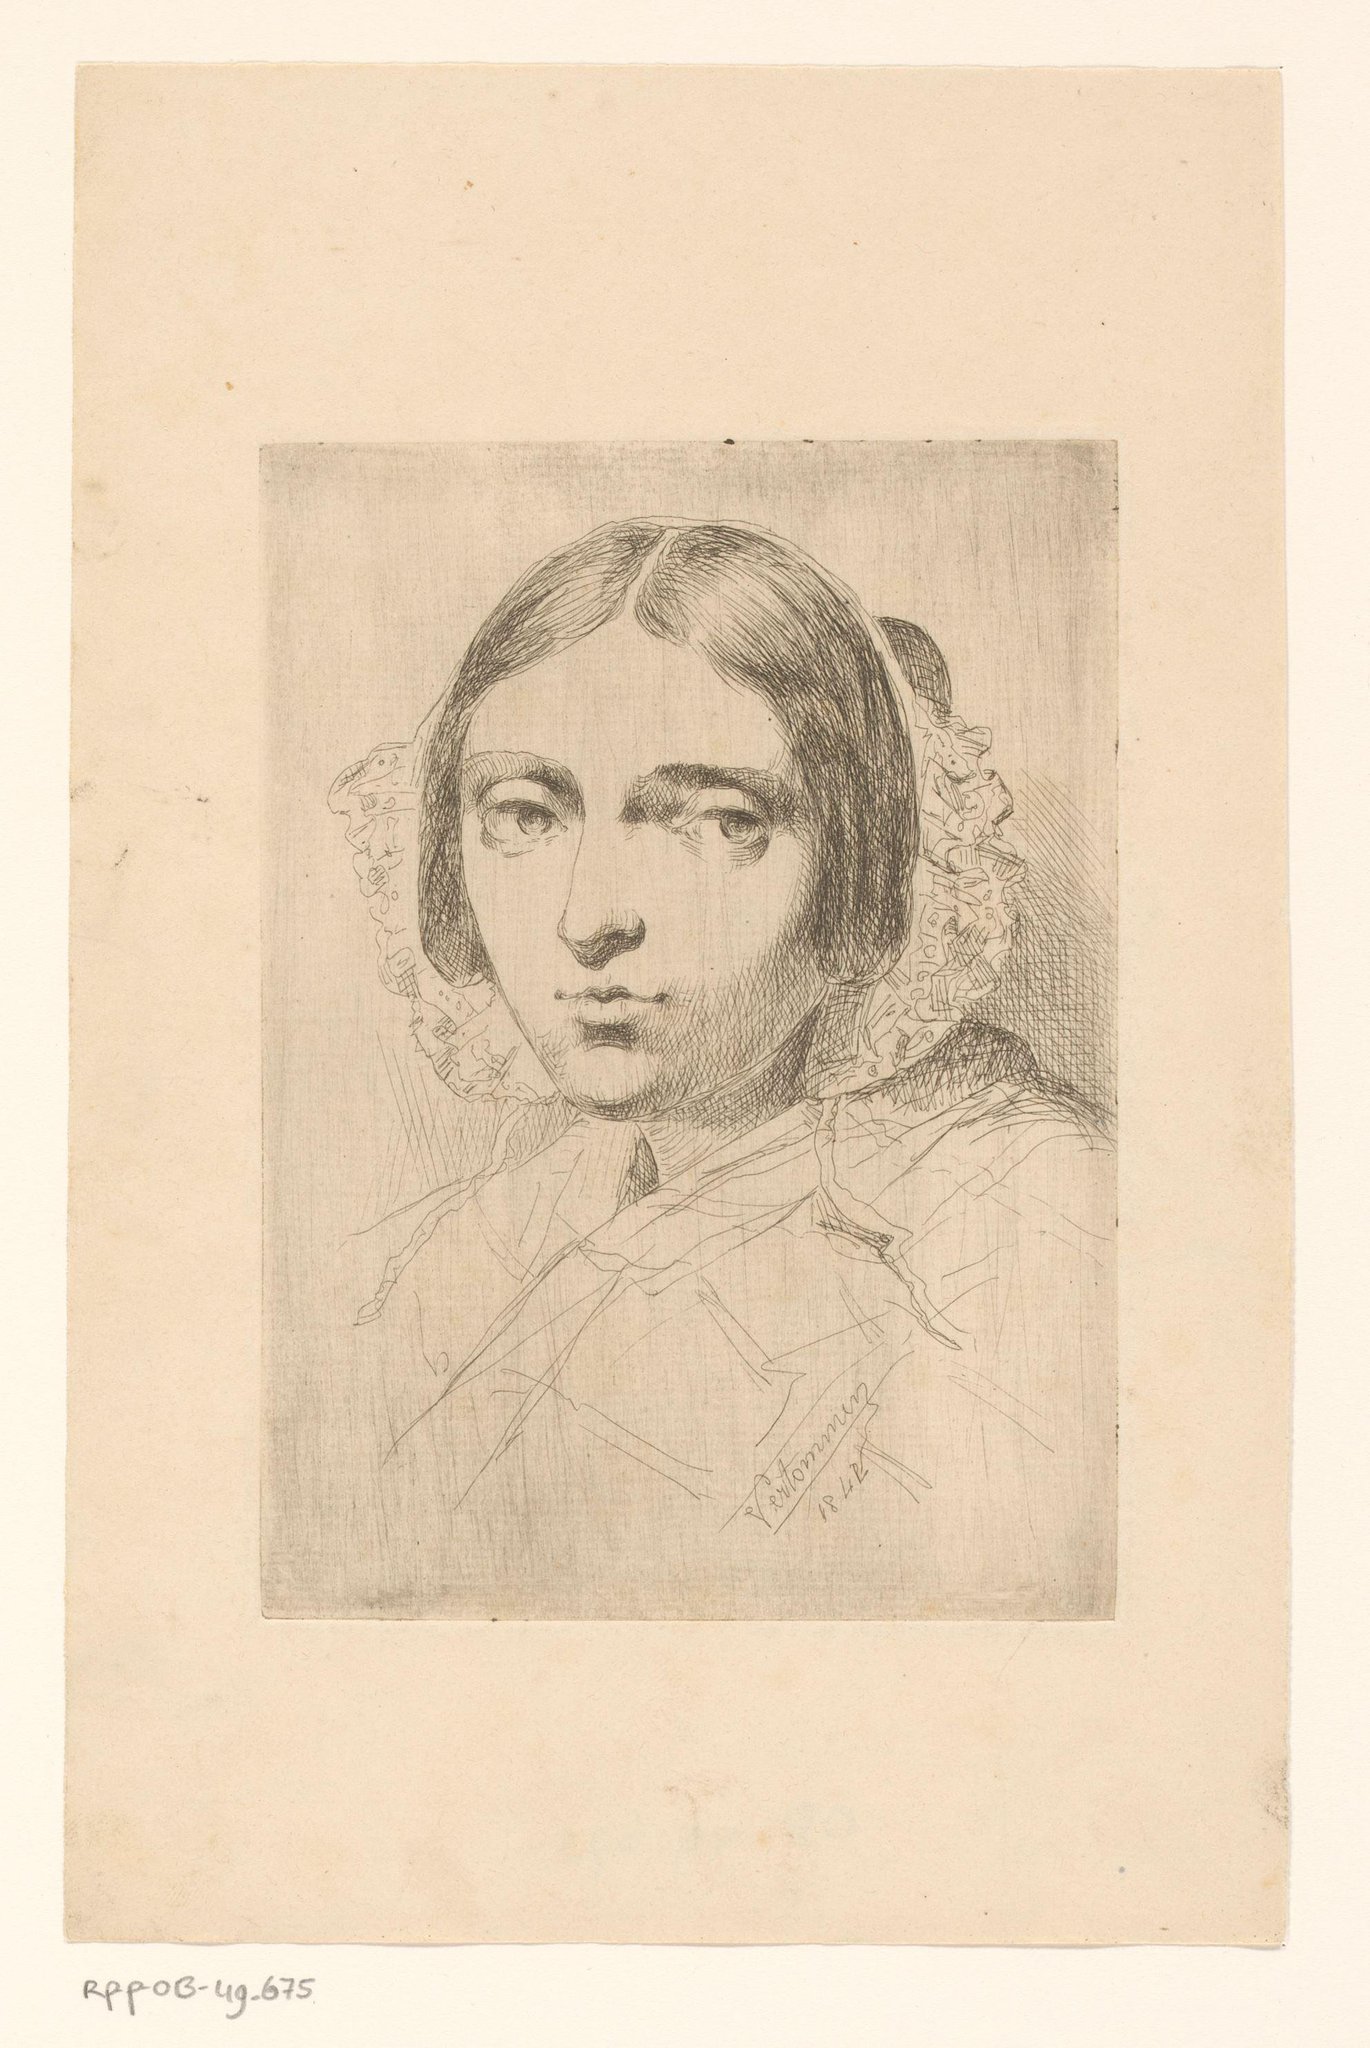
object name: print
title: Hoofd van een vrouw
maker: guillaume joseph vertommen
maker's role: print maker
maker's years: 1815-1863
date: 1841-1842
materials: paper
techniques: etching, intaglio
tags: adult woman, head-gear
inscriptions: collector's mark: Lugt 2228